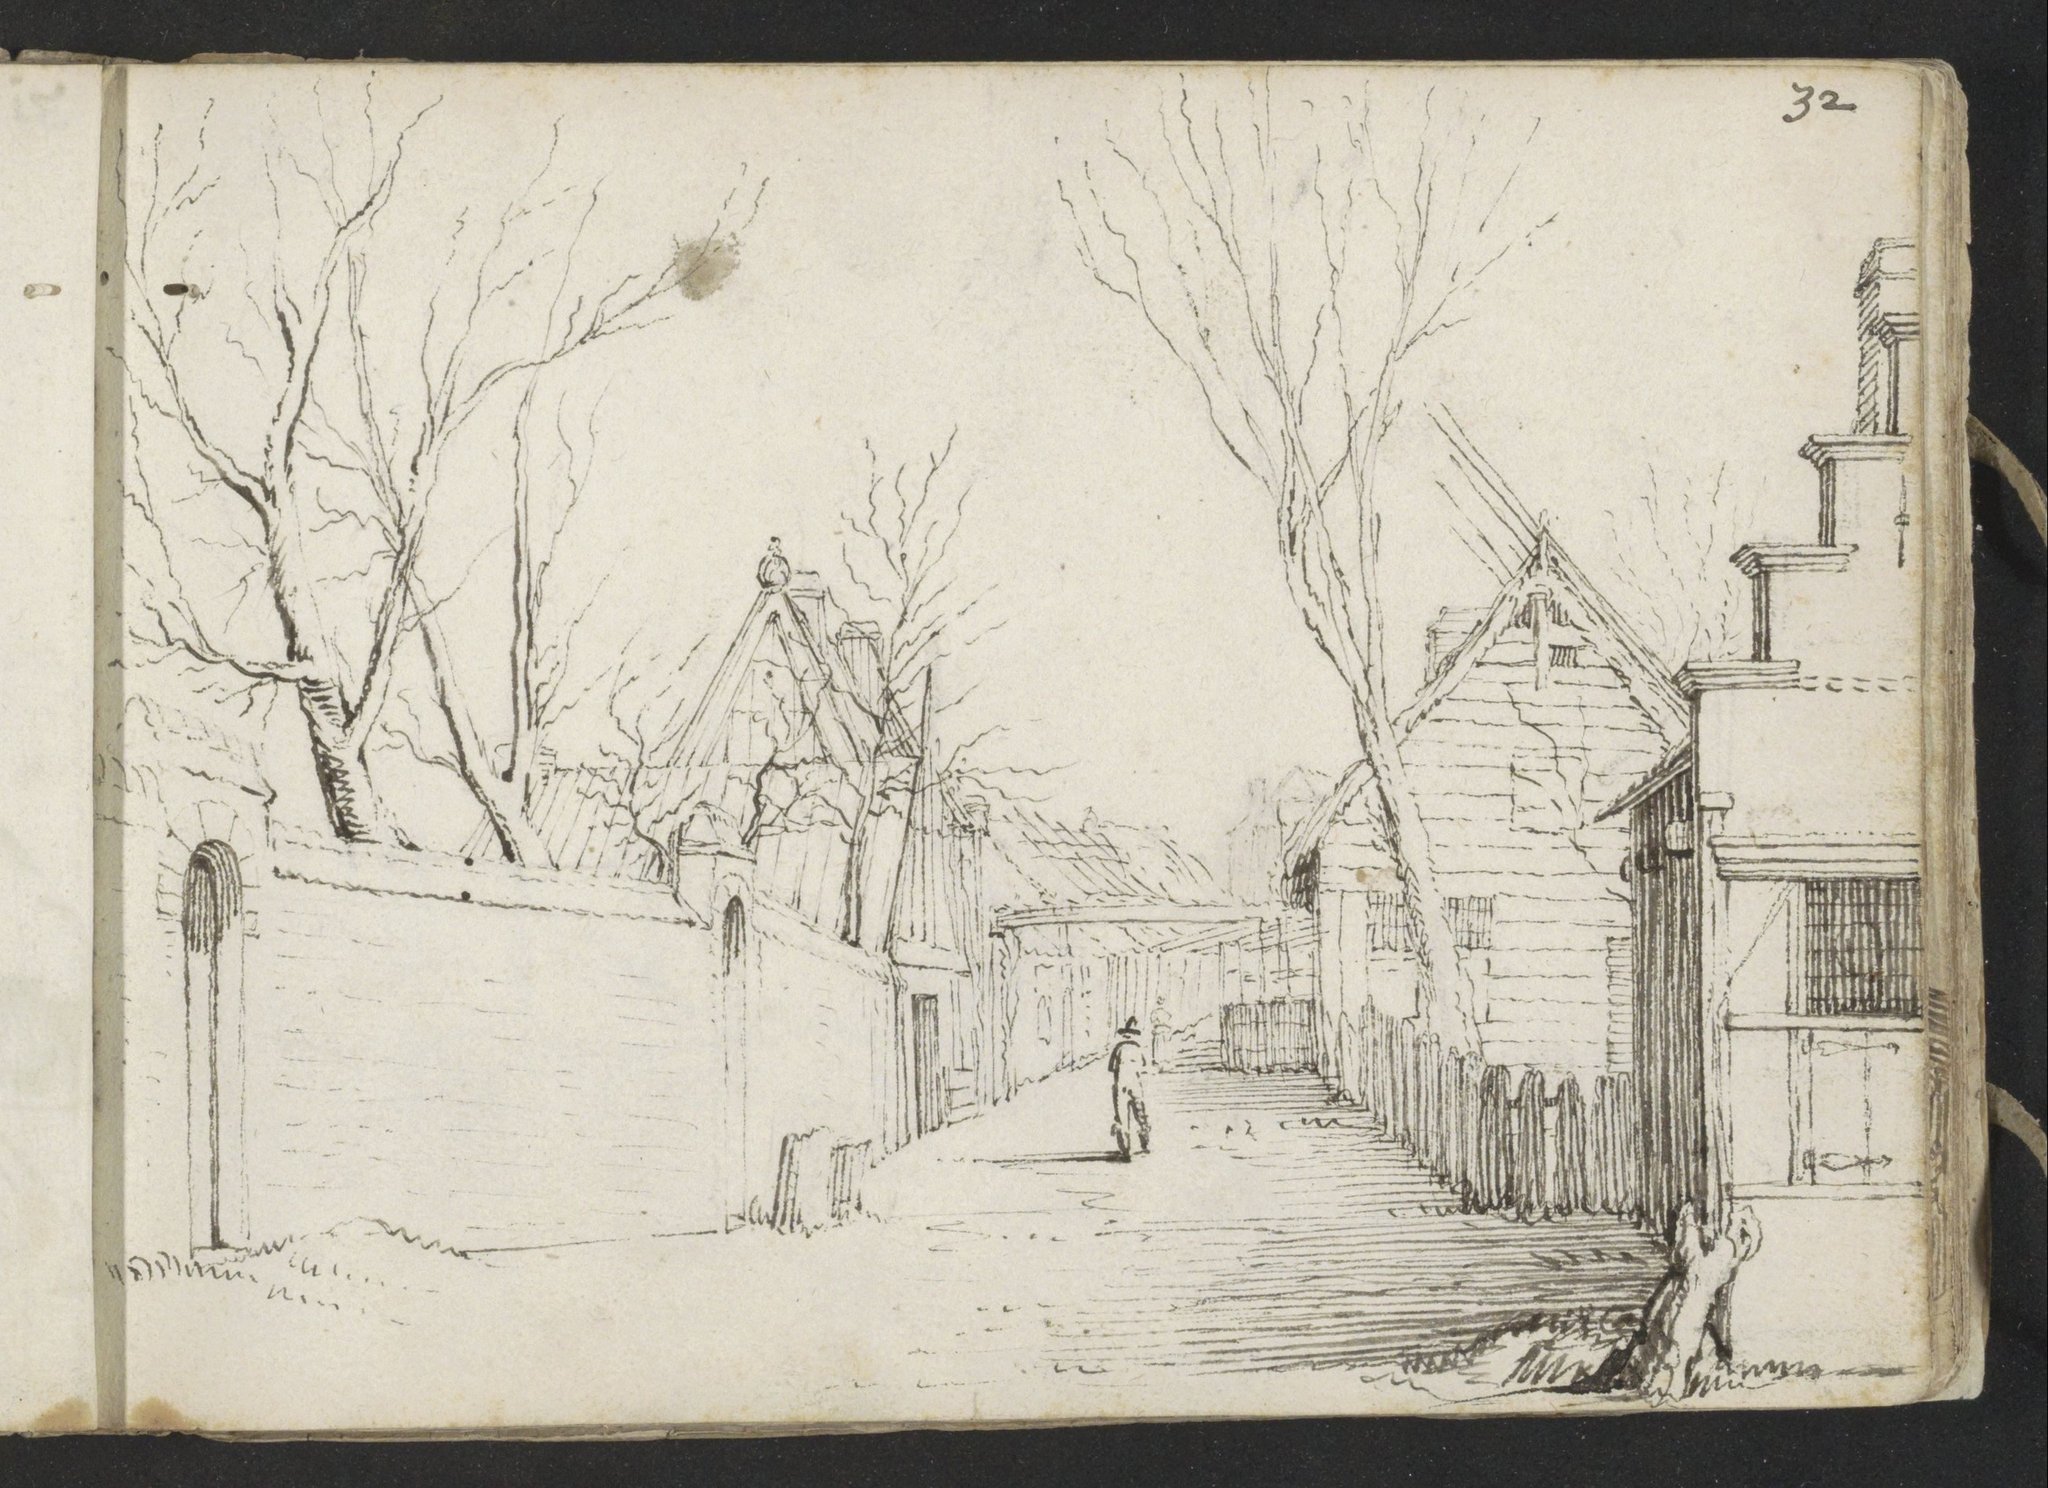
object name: sketchbook leaf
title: Man op een straat te Zwolle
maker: gerard ter borch (ii)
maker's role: draughtsman, painter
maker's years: 1617-1681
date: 1631-1633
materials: ink, paper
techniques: pen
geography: zwolle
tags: street (+ city(-scape) with figures, staffage)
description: Blad 32 recto uit een schetsboek met 55 bladen.